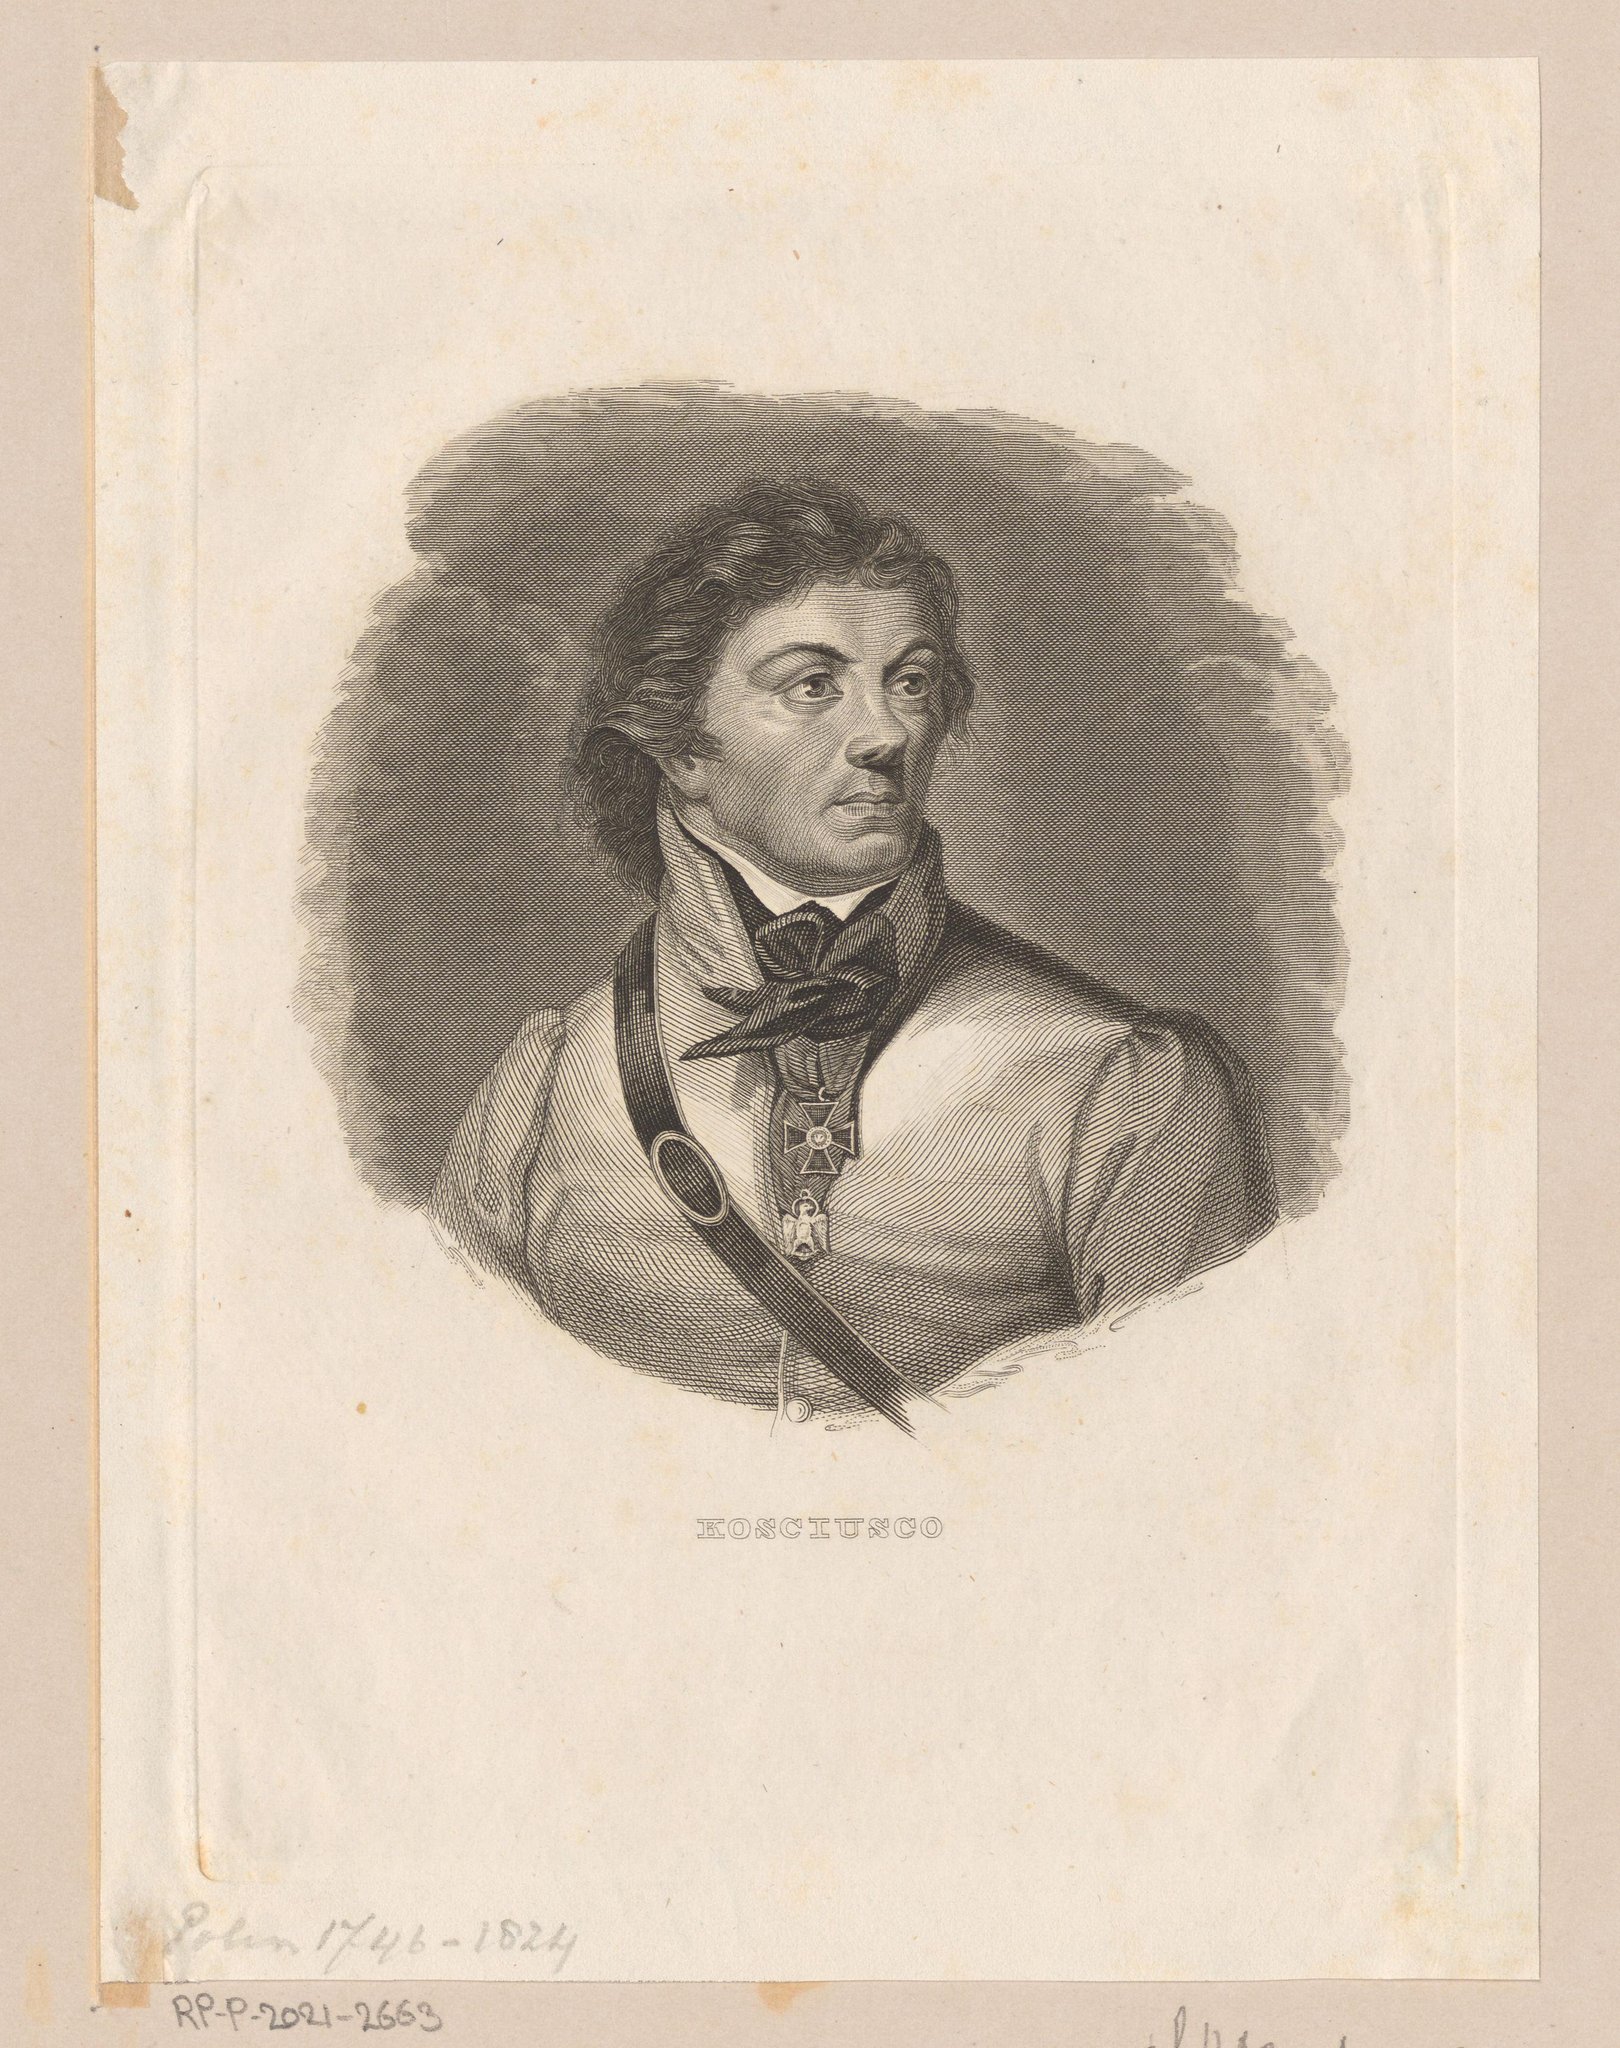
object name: print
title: Portret van Andrzej Tadeusz Bonawentura Kościuszko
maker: Anonymous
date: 1794-1899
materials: paper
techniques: engraving, etching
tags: historical persons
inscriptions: collector's mark: Lugt 2228